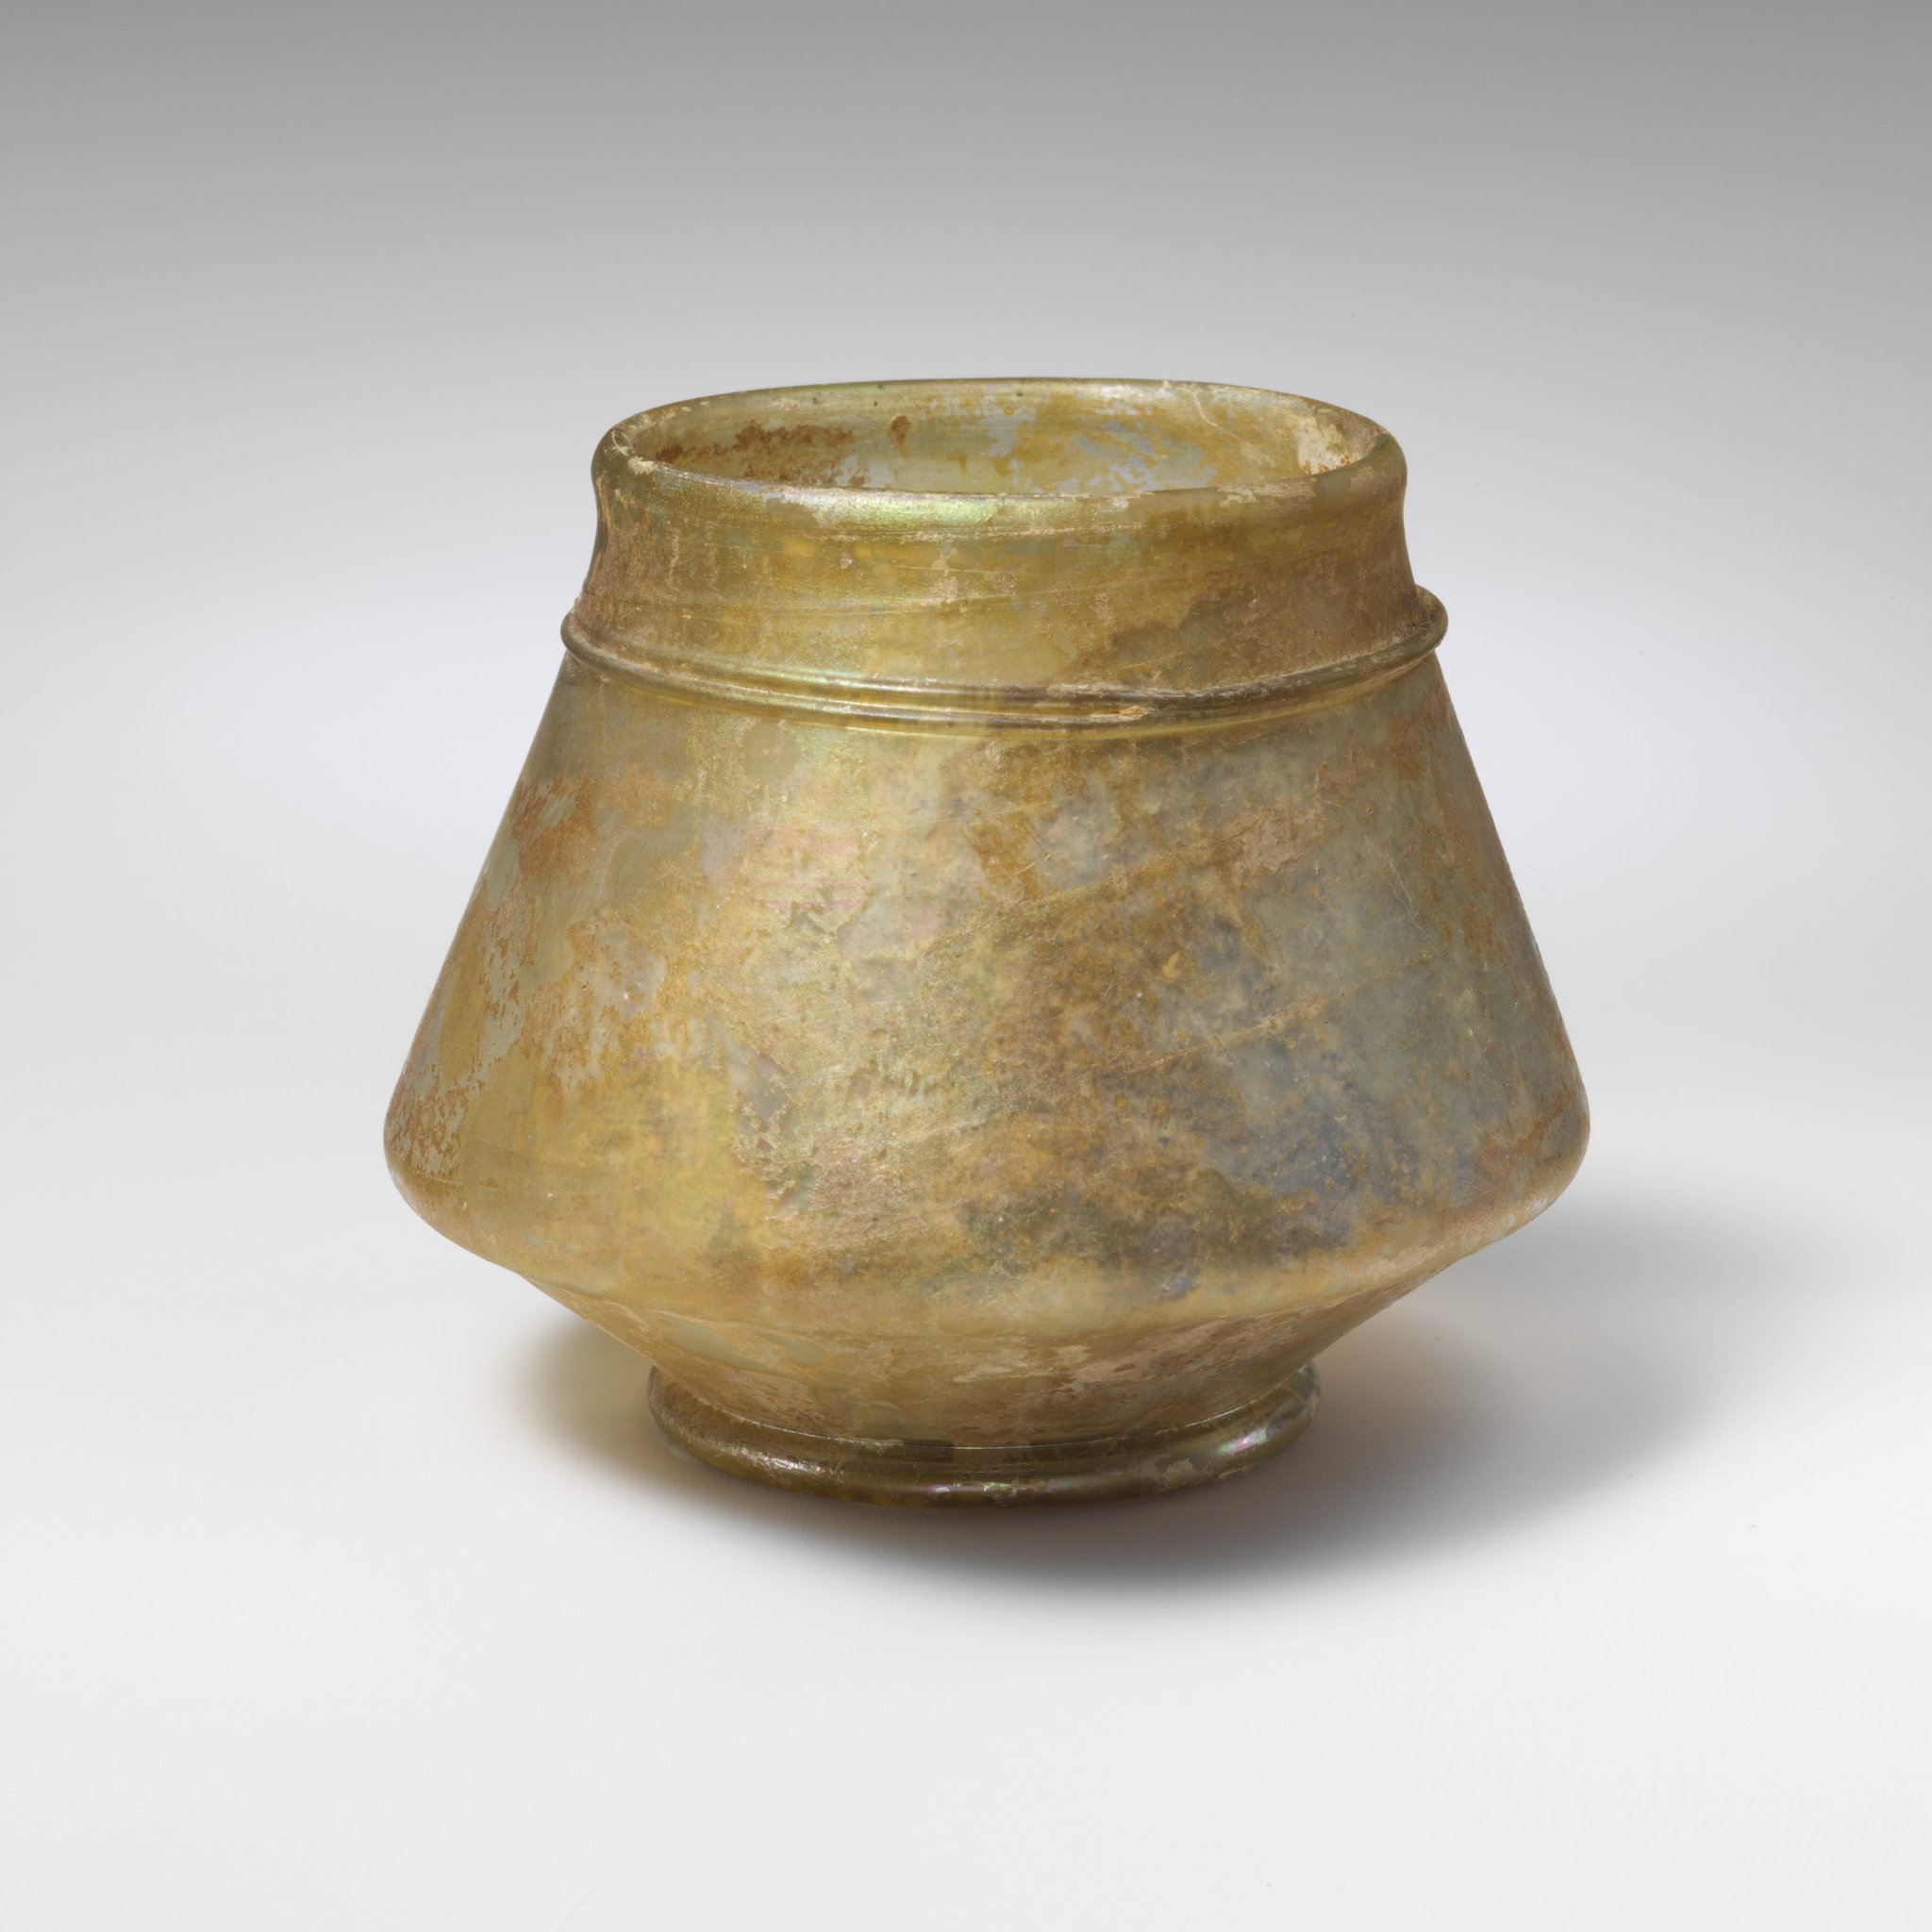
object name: cup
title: Glass cup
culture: roman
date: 101-300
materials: glass